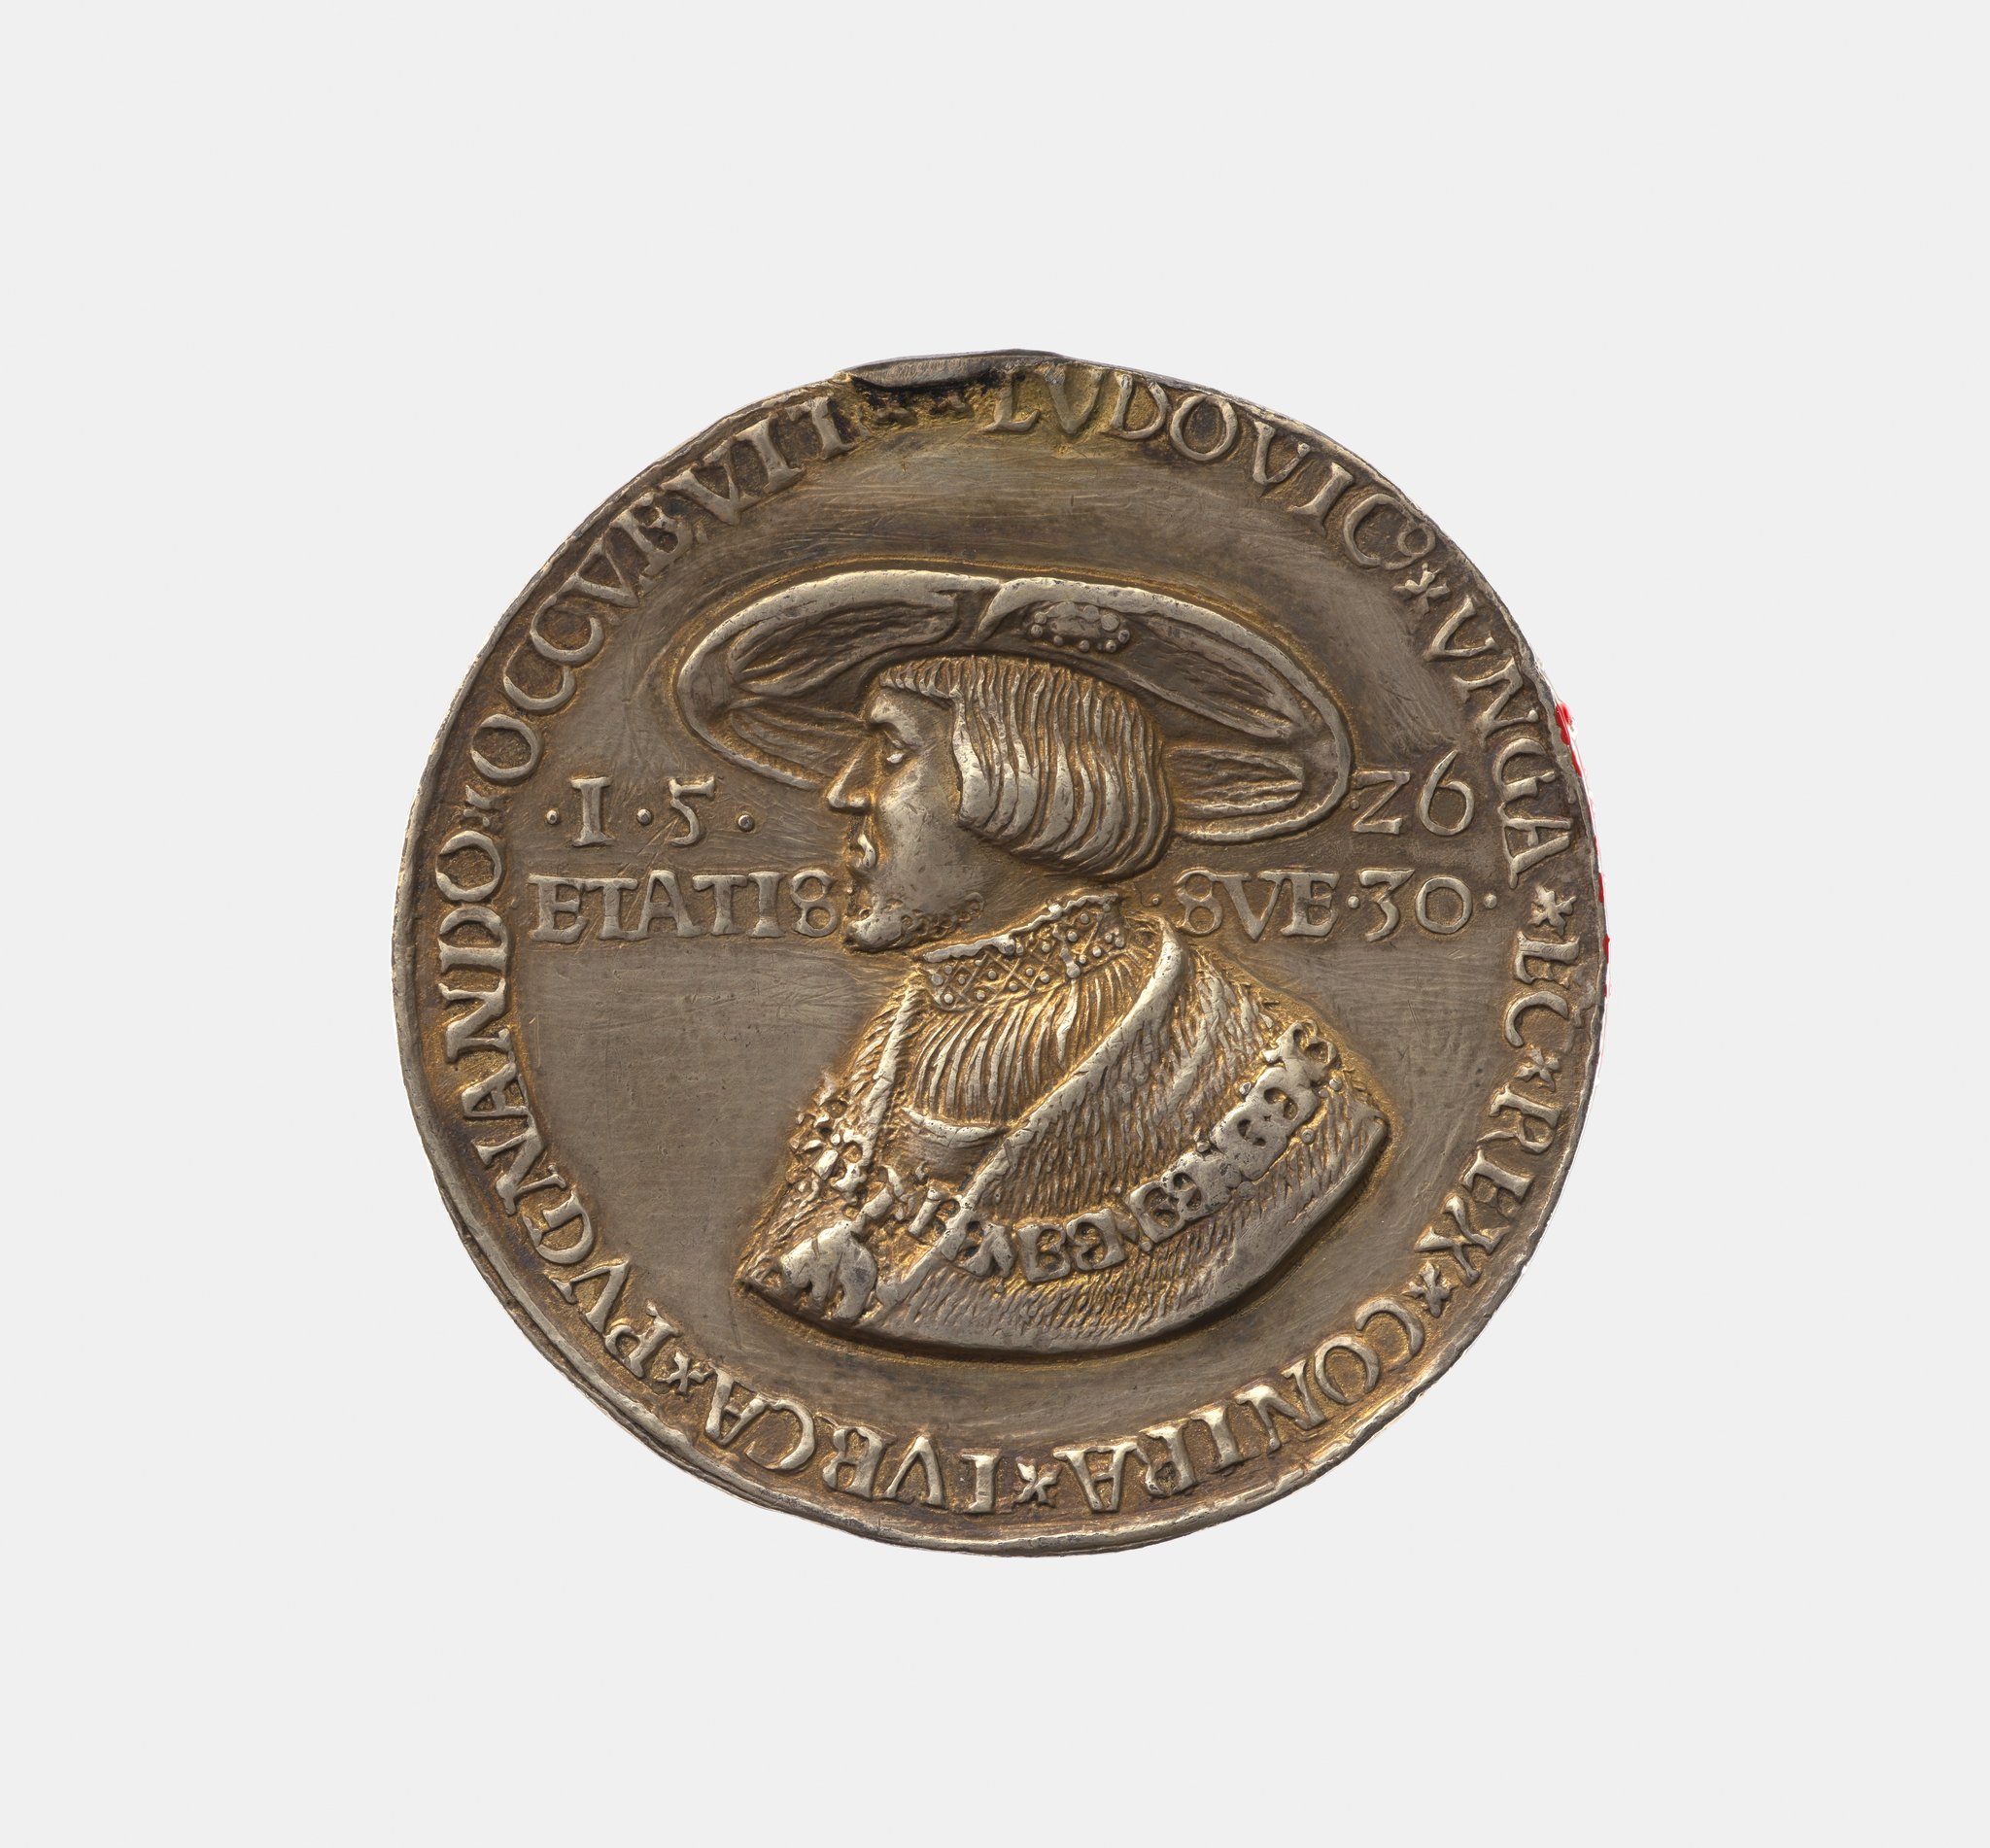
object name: medal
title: Louis II 1506-26, King of Hungary 1516-26, and his wife Maria (1505–1558), sister of Charles V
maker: michael hohenauer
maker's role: artist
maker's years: 1500-1560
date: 1526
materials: silver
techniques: gilding